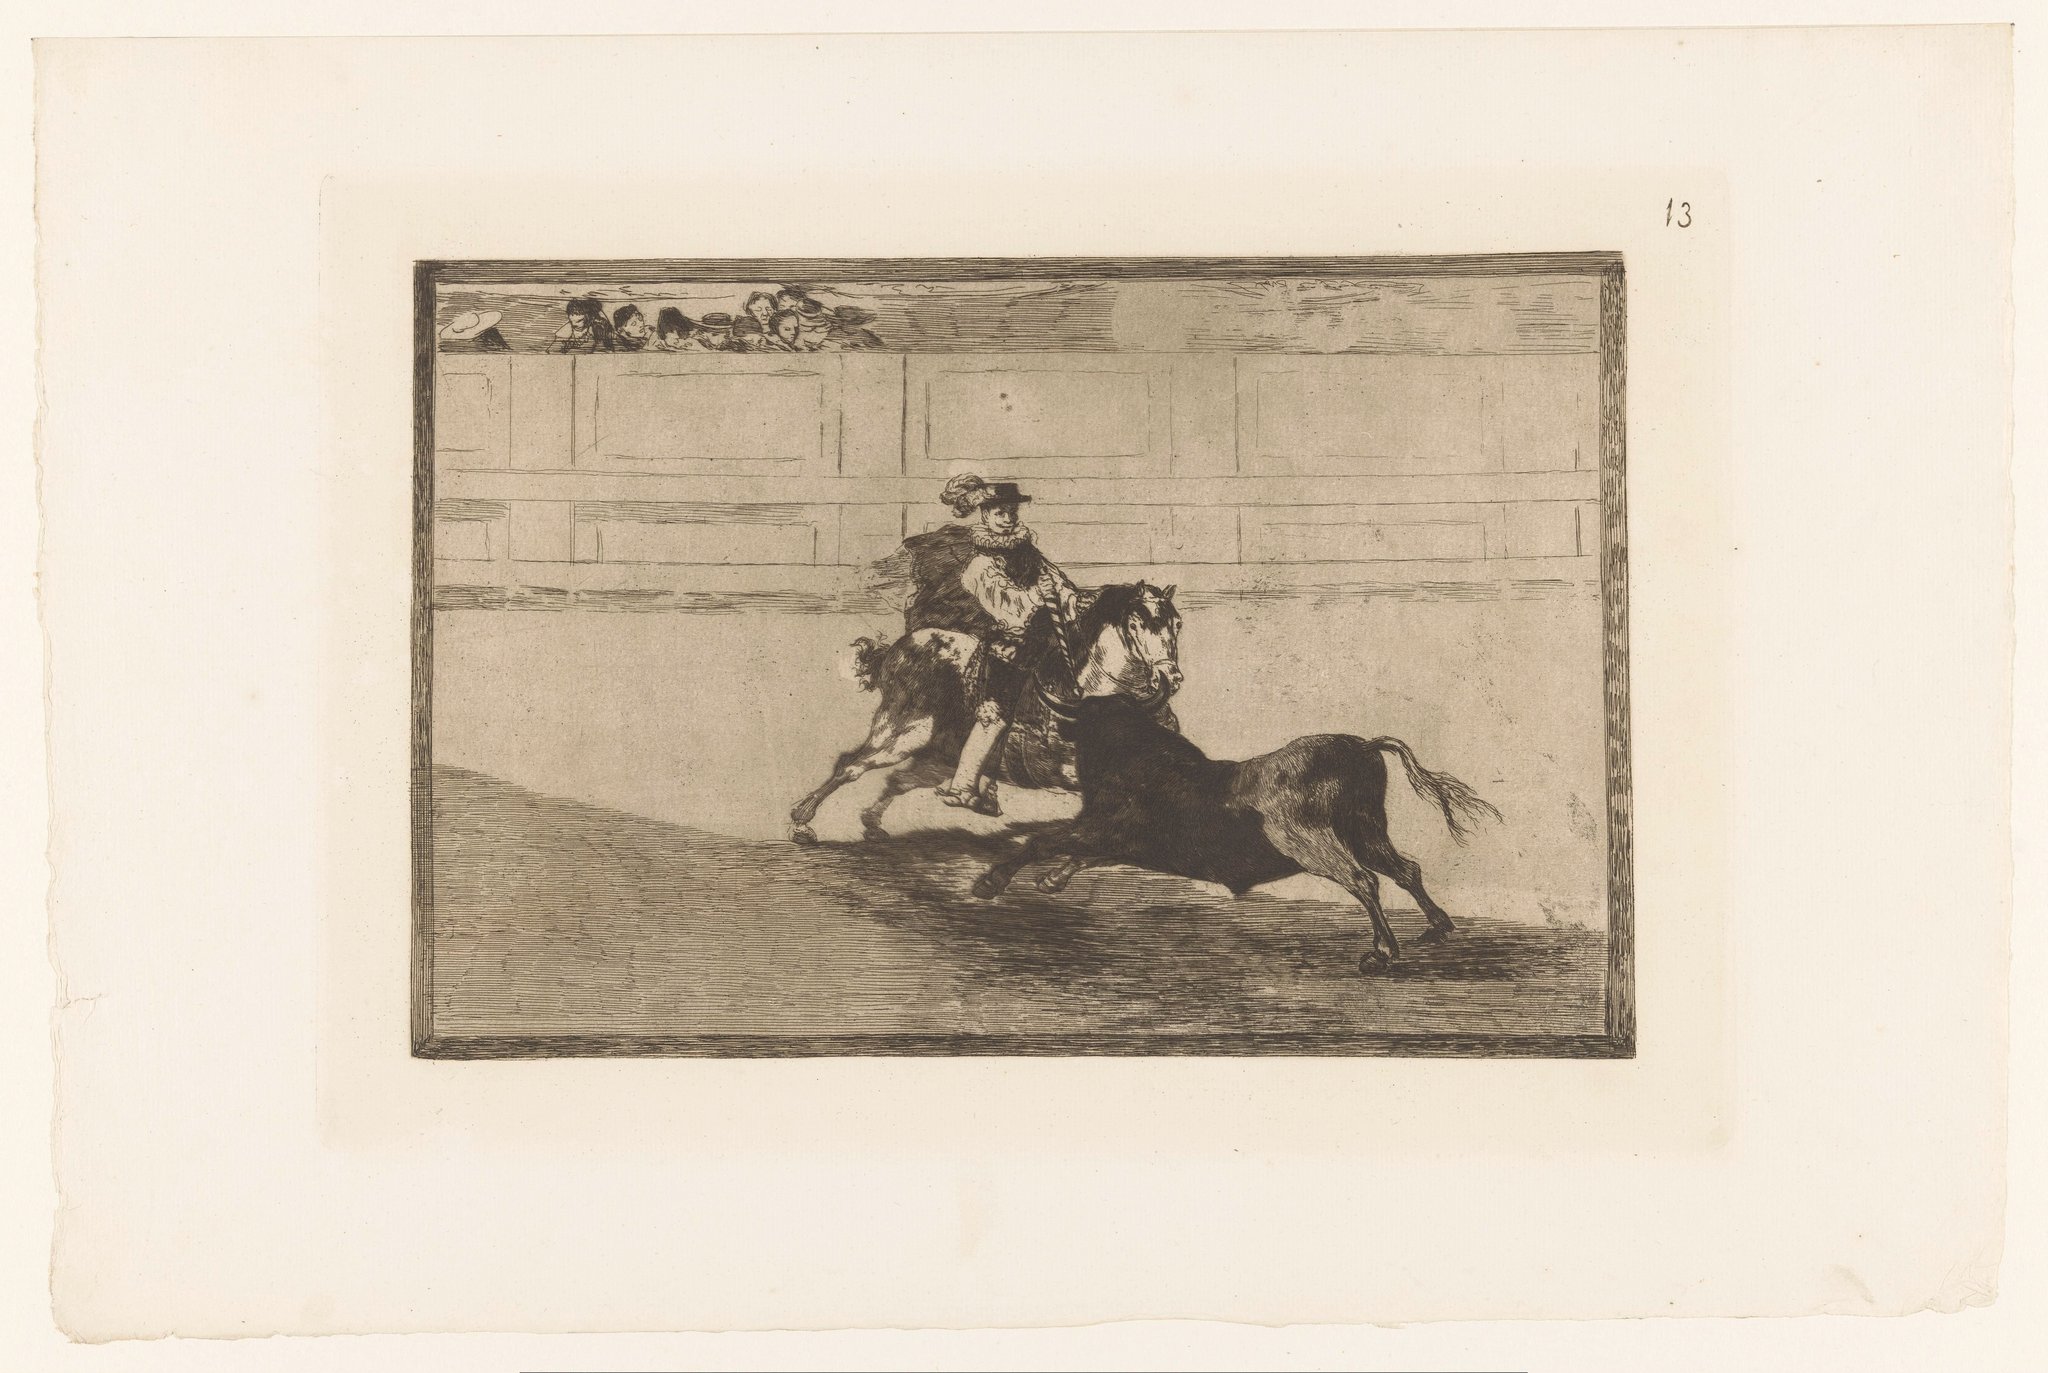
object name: print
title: Un caballero Español en plaza quebrando rejoncillos sin auxilio de los chulos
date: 1876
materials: paper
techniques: aquatint, etching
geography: spain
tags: riding a horse, ass, or mule; rider, horseman, bull, bullfight, bull-fighter, toreador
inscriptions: collector's mark: Lugt 2228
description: Deze prent maakt deel uit van een serie van 40 prenten door Francisco de Goya met voorstellingen van stierengevechten. De eerste editie bestond uit 33 genummerde prenten en werd uitgegeven in 1816. Dit betreft de derde editie, uitgegeven in 1876 door Eugène Loizelet en door hem voorzien van een titelprent en lijst met titels. Naast de 33 prenten publiceerde Loizelet ook de prenten die door Goya op de achterkanten van 7 van de platen werden geëtst. Deze zijn niet voorzien van nummers maar van de letters A-G.